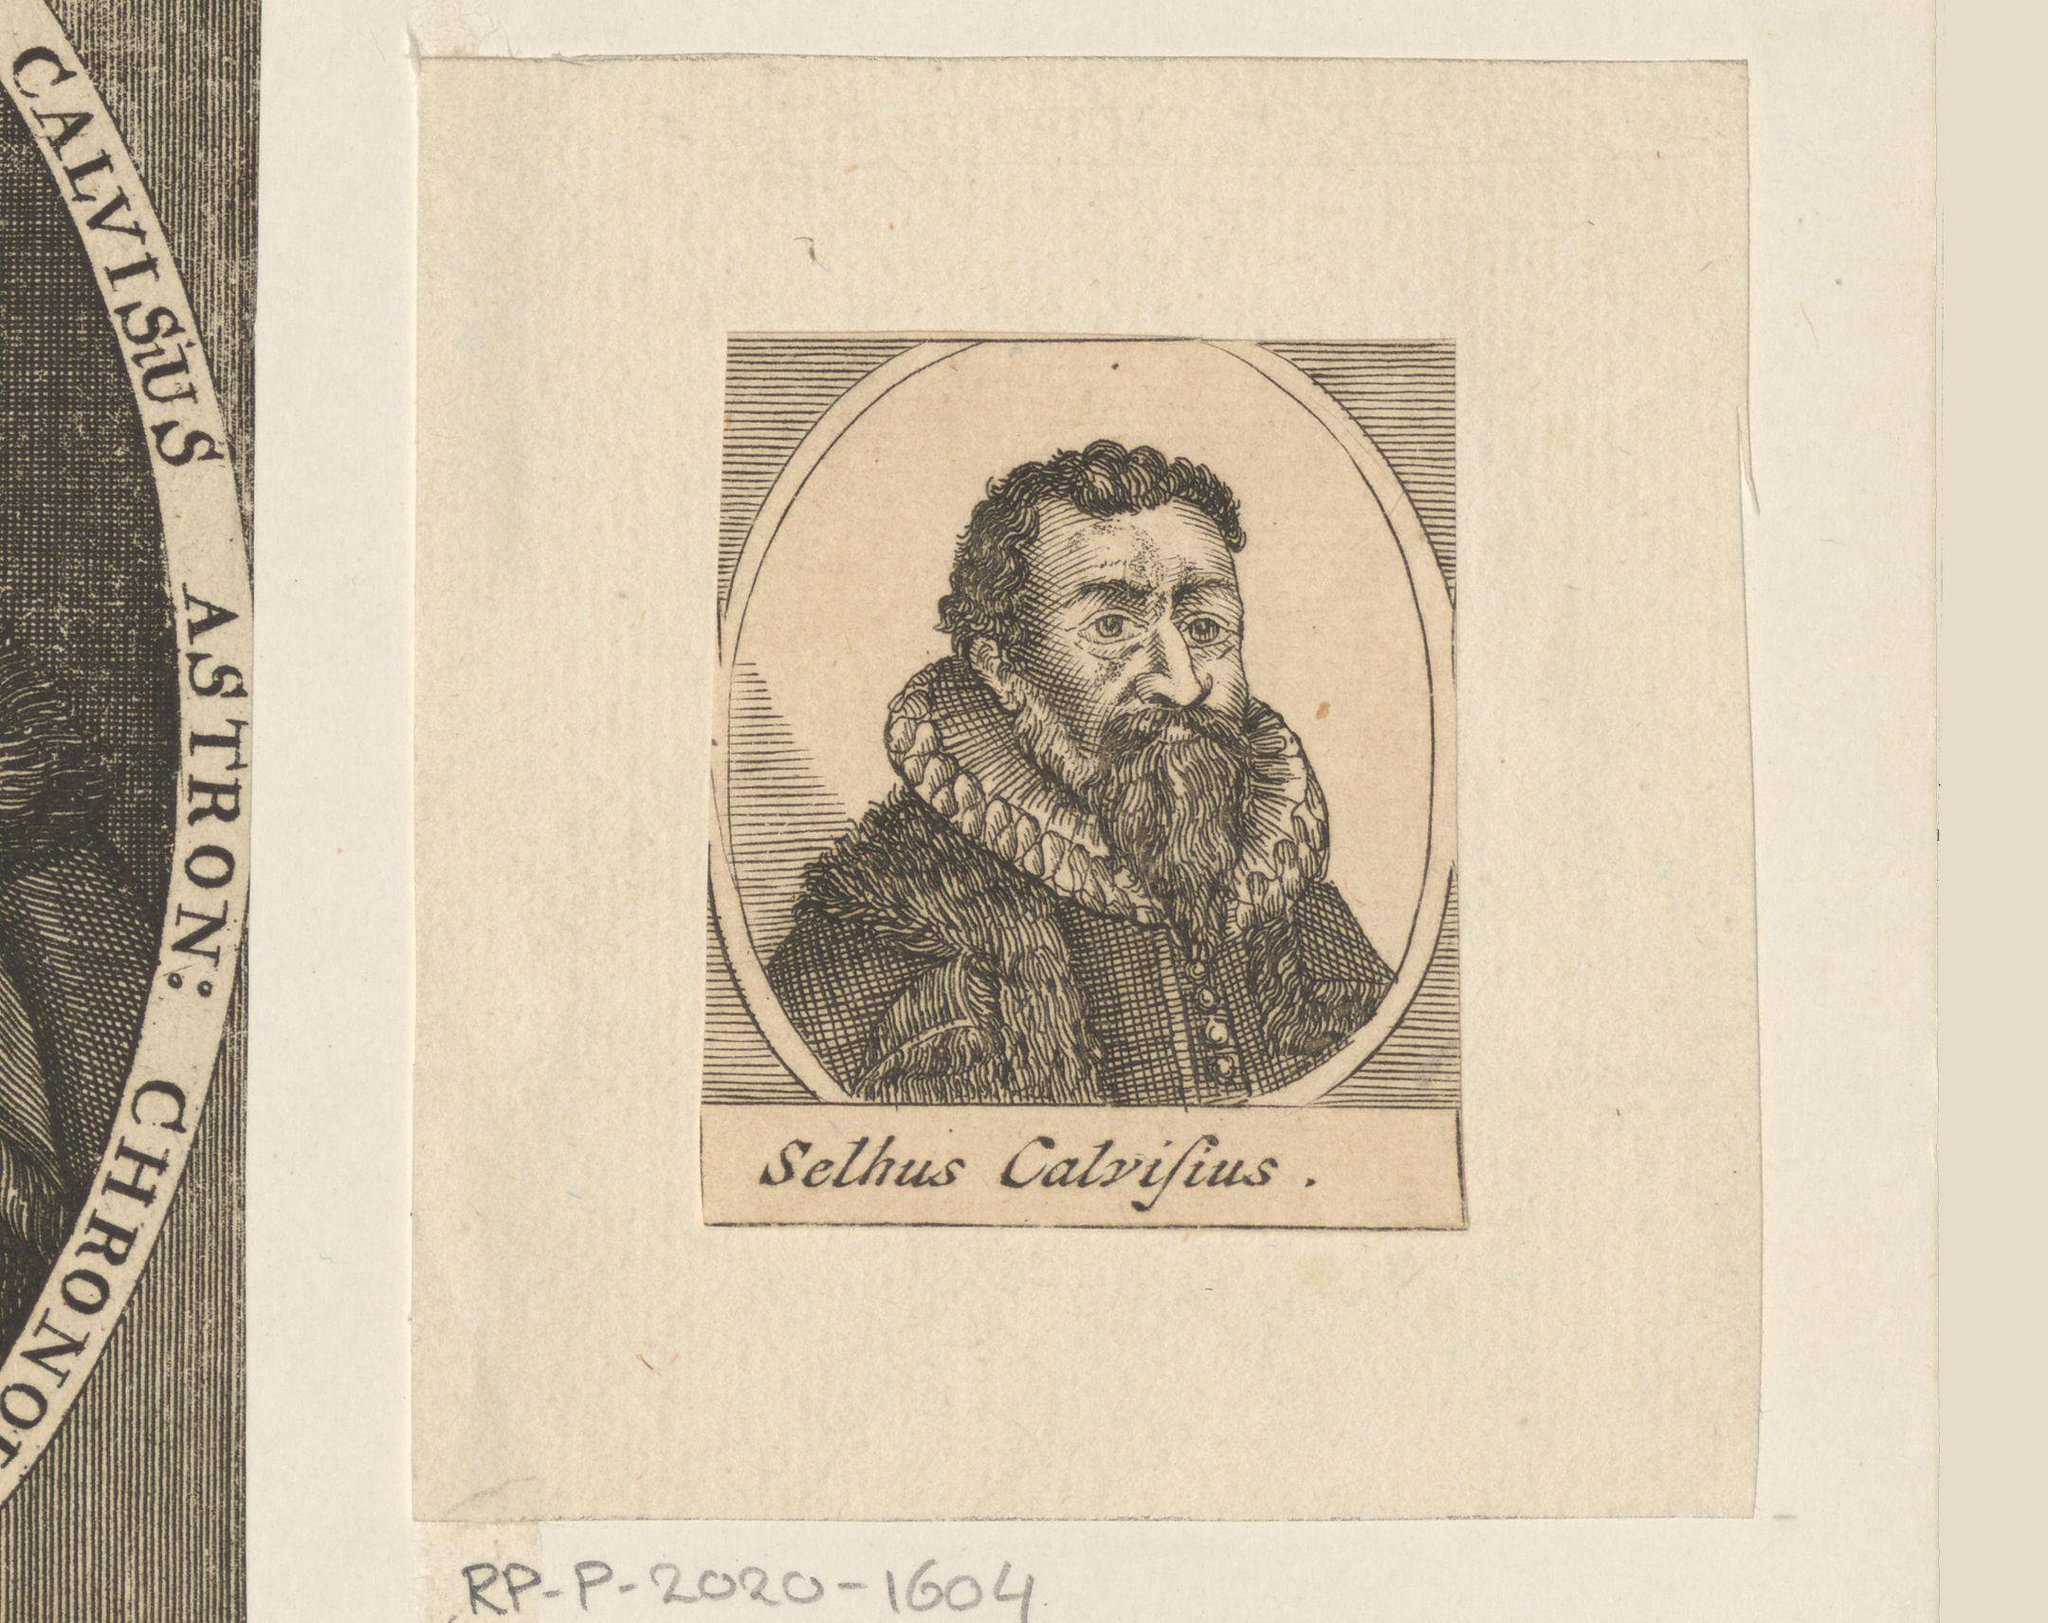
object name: print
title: Portret van Sethus Calvisius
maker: Anonymous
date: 1600-1699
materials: paper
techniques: engraving, etching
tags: publisher, sethus calvisius, historical persons